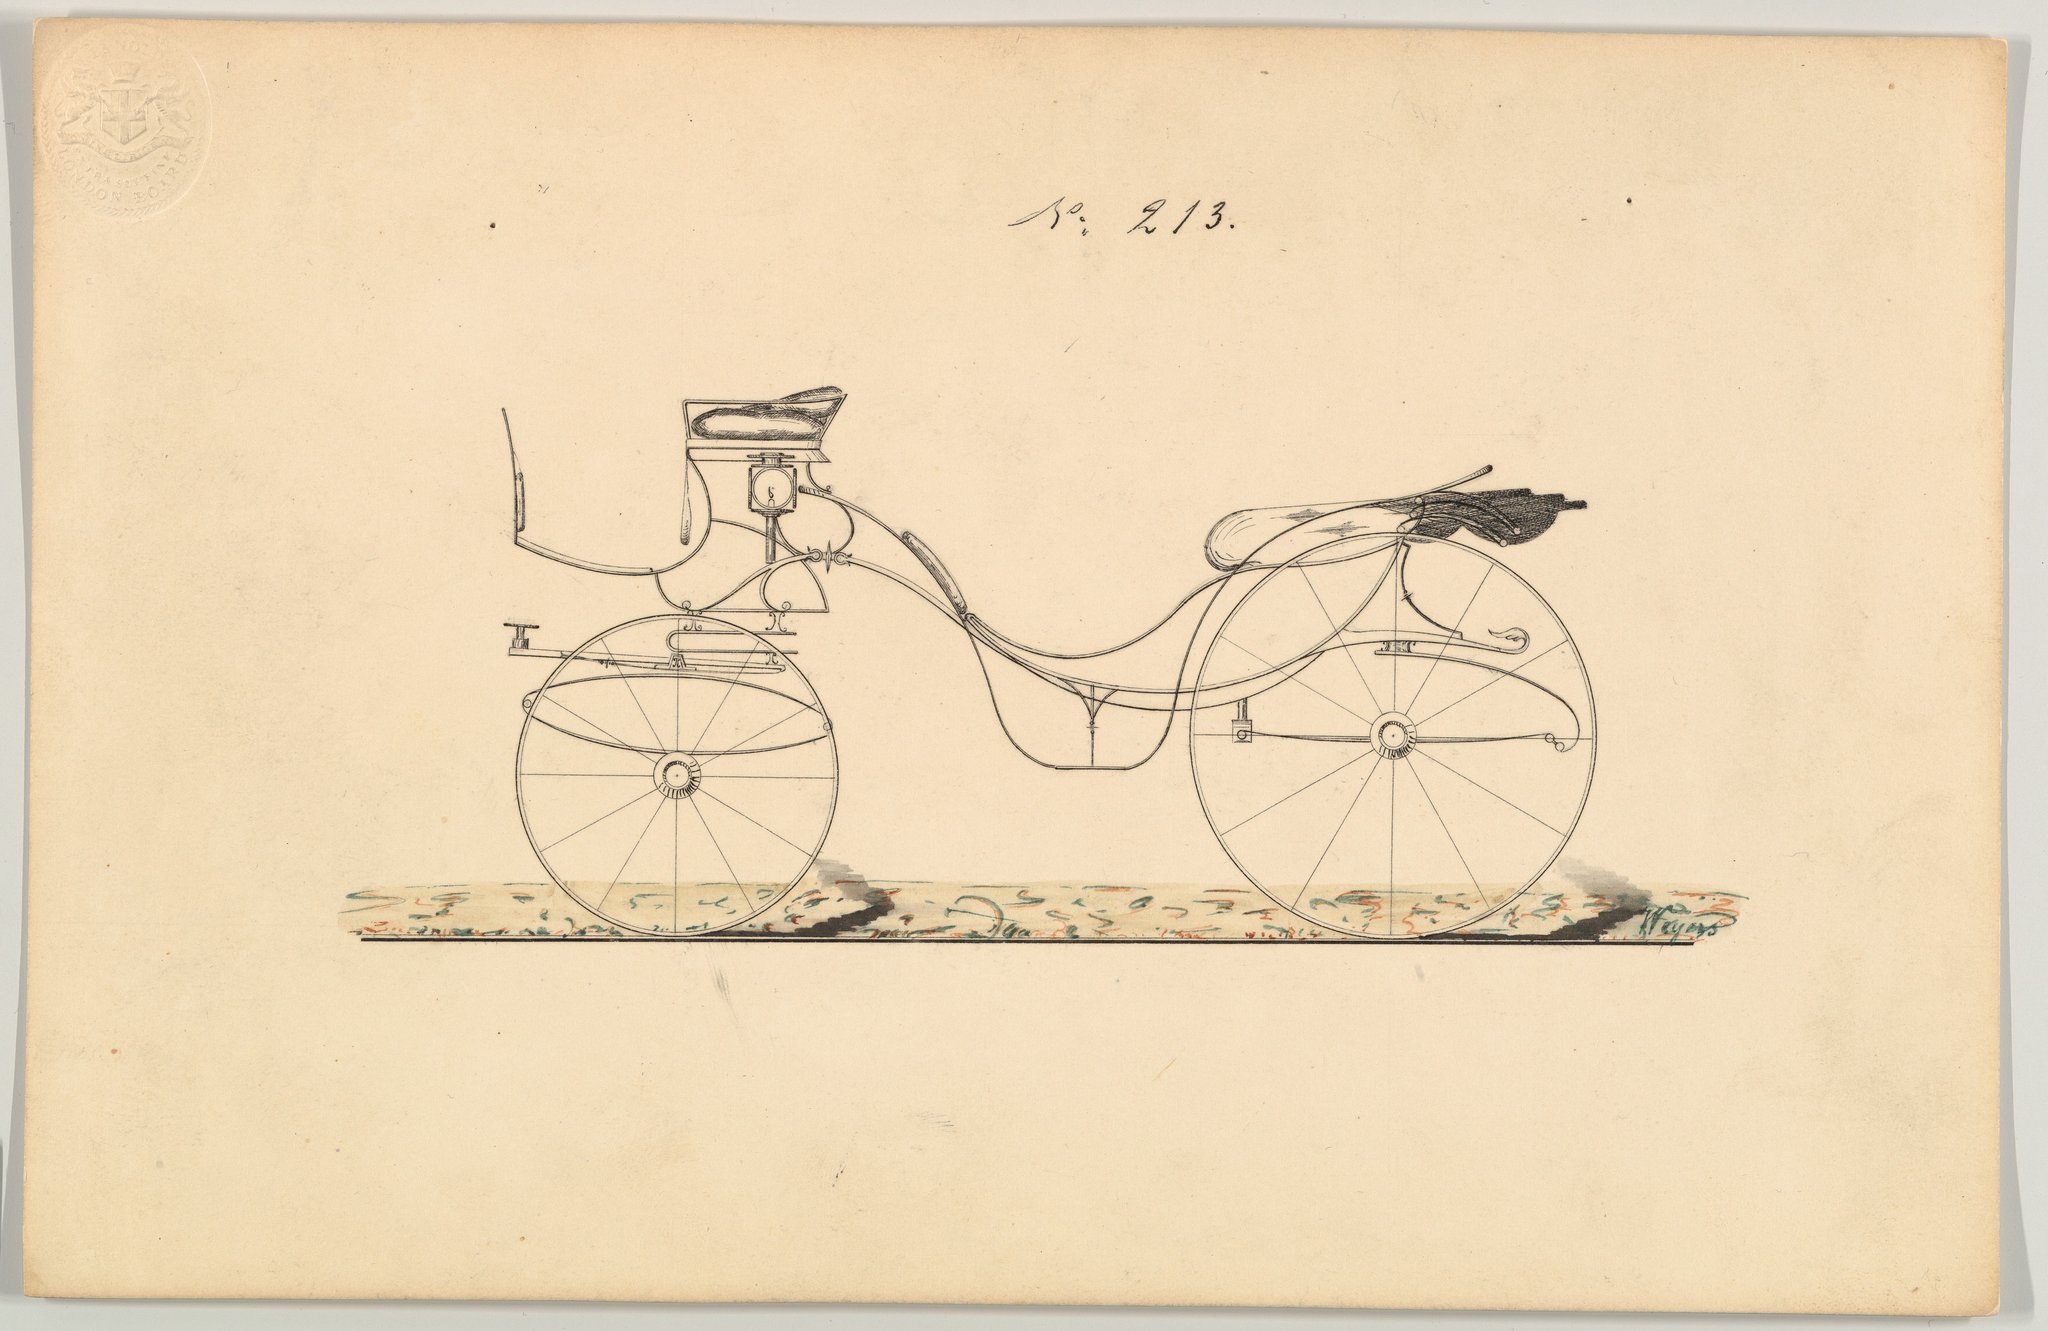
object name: drawing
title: Victoria #213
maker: brewster & co.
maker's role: manufacturer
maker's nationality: american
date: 1884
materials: ink, watercolor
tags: carriages